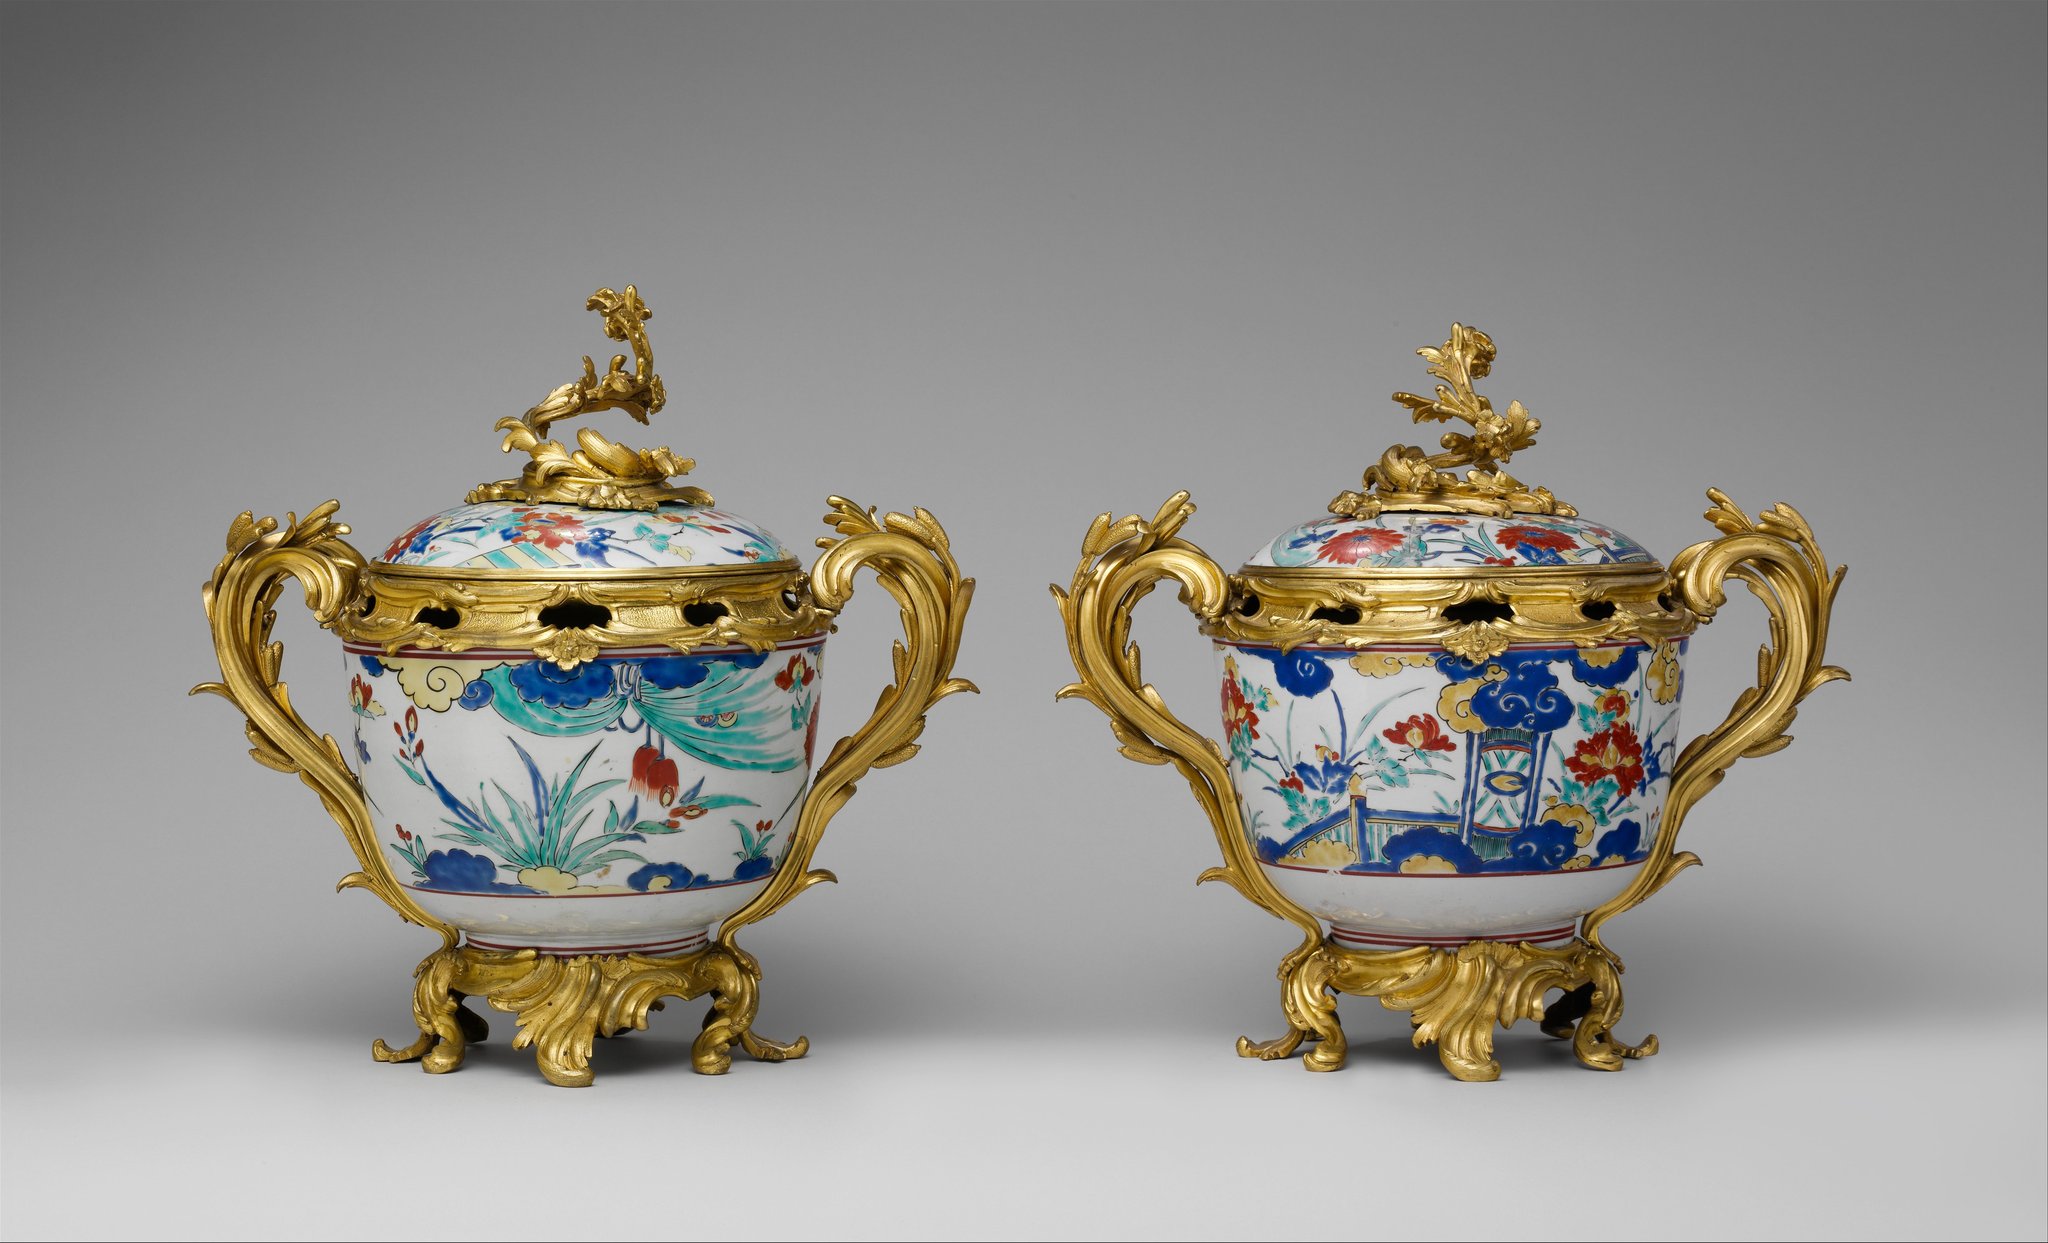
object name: potpourri bowl with cover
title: Potpourri bowl with cover (one of a pair)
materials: gilt bronze, hard paste porcelain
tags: flowers